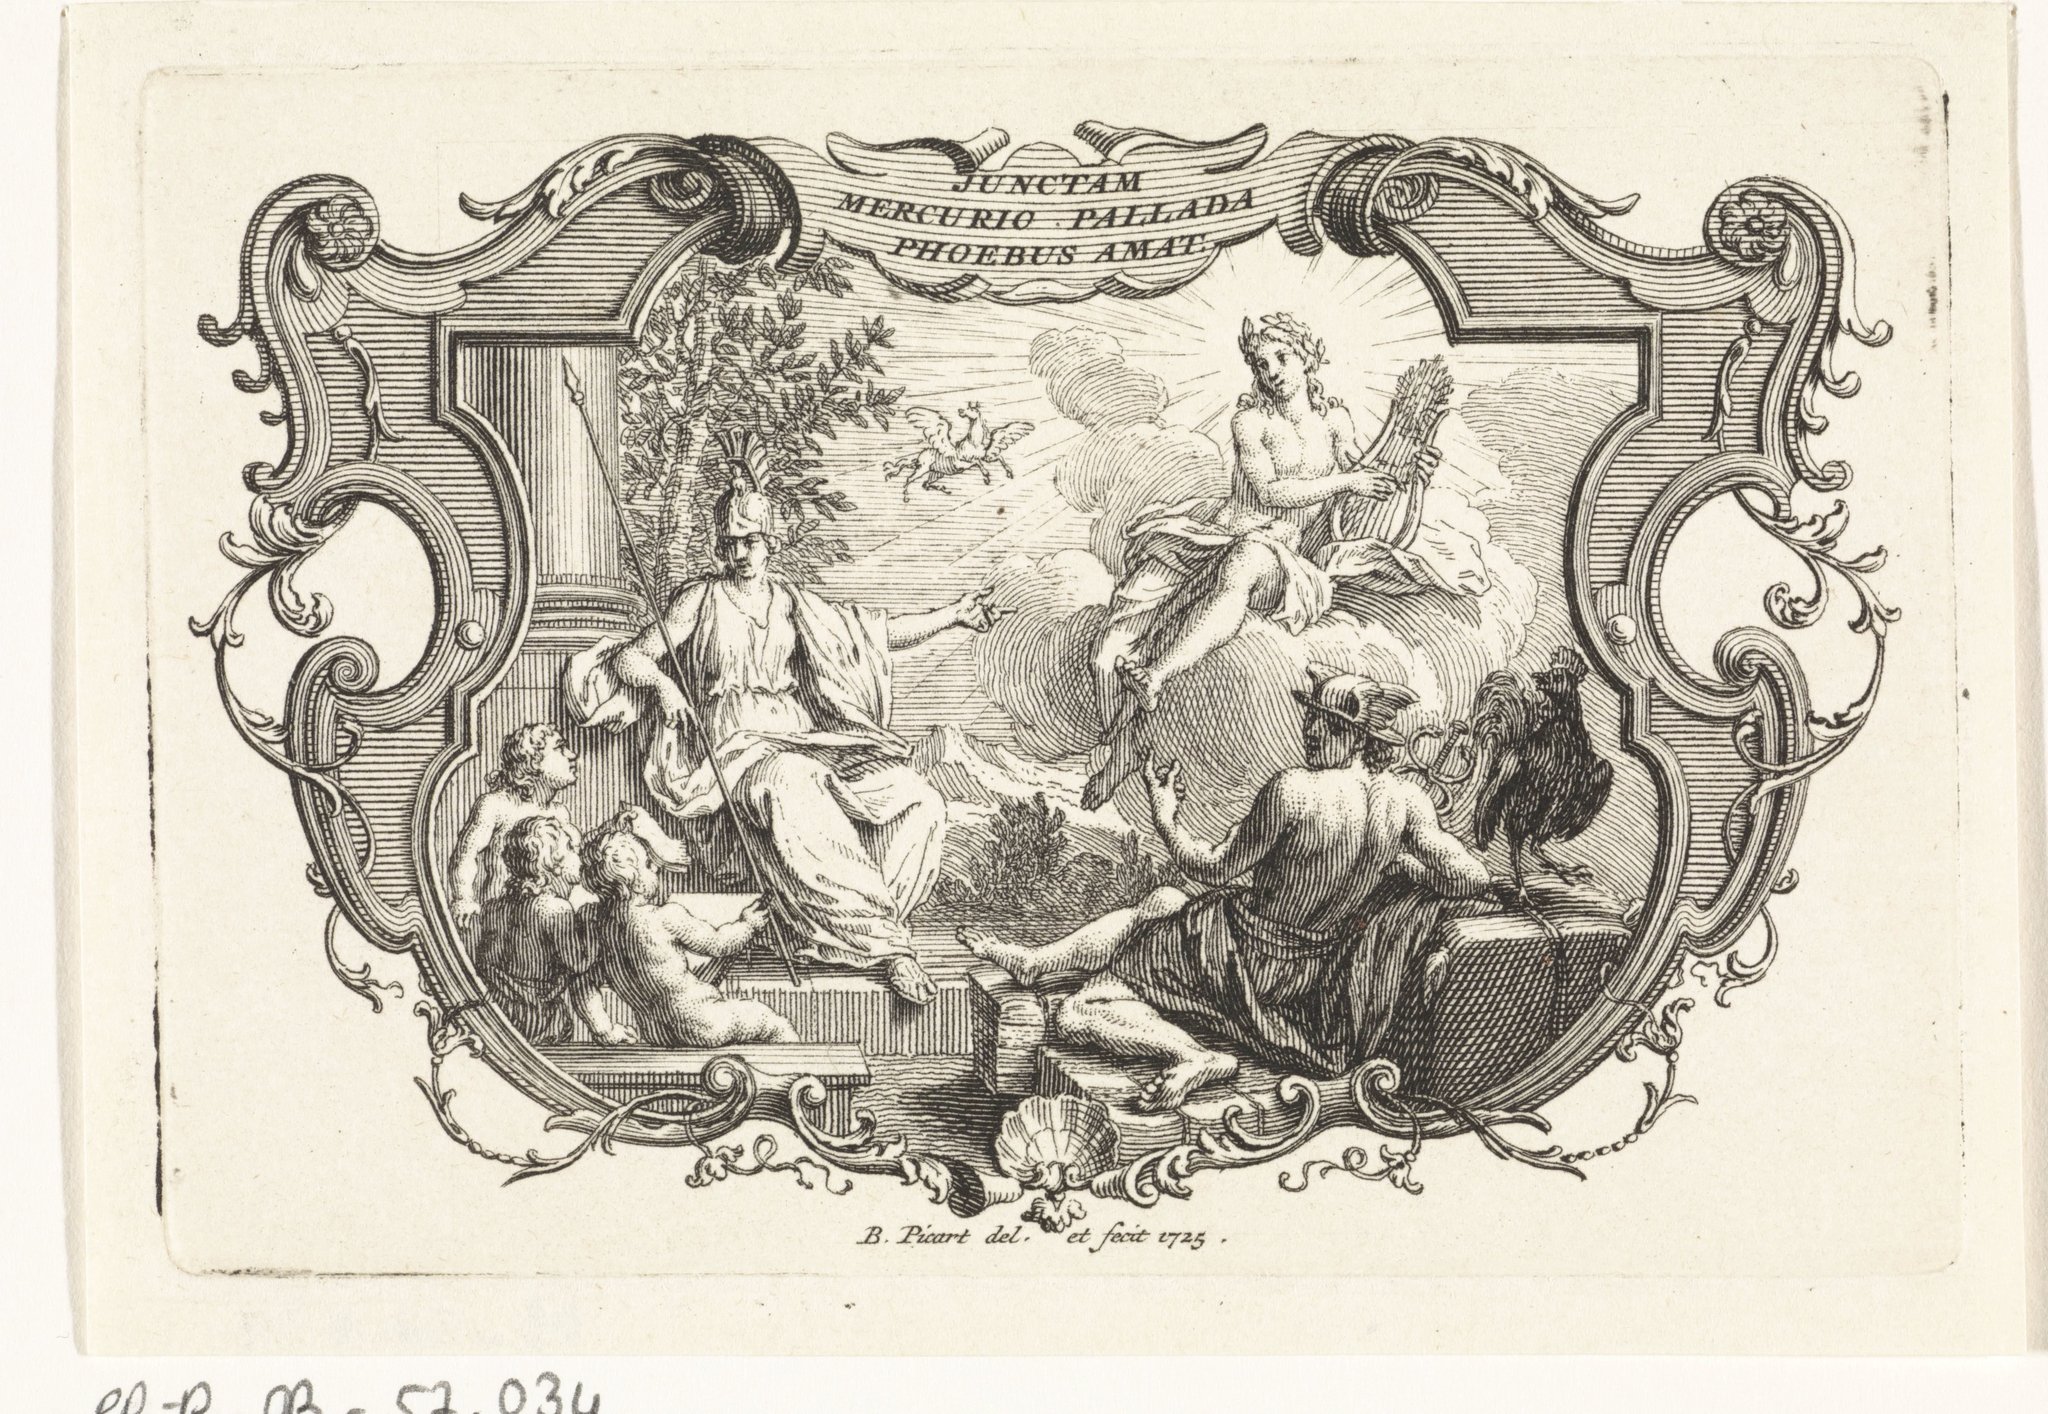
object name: print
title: Apollo, Minerva en Mercurius bijeen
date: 1725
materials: paper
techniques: engraving, etching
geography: amsterdam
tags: pegasus, the winged horse, ornaments ~ art, (story of) apollo (phoebus), (story of) minerva (pallas, athena), (story of) mercury (hermes)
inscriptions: collector's mark: Lugt 2228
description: Minerva en Mercurius wijzen op de op een wolk tronende Apollo. Boven de voorstelling het devies: Junctam Mercurio Pallada Phoebus Amat.